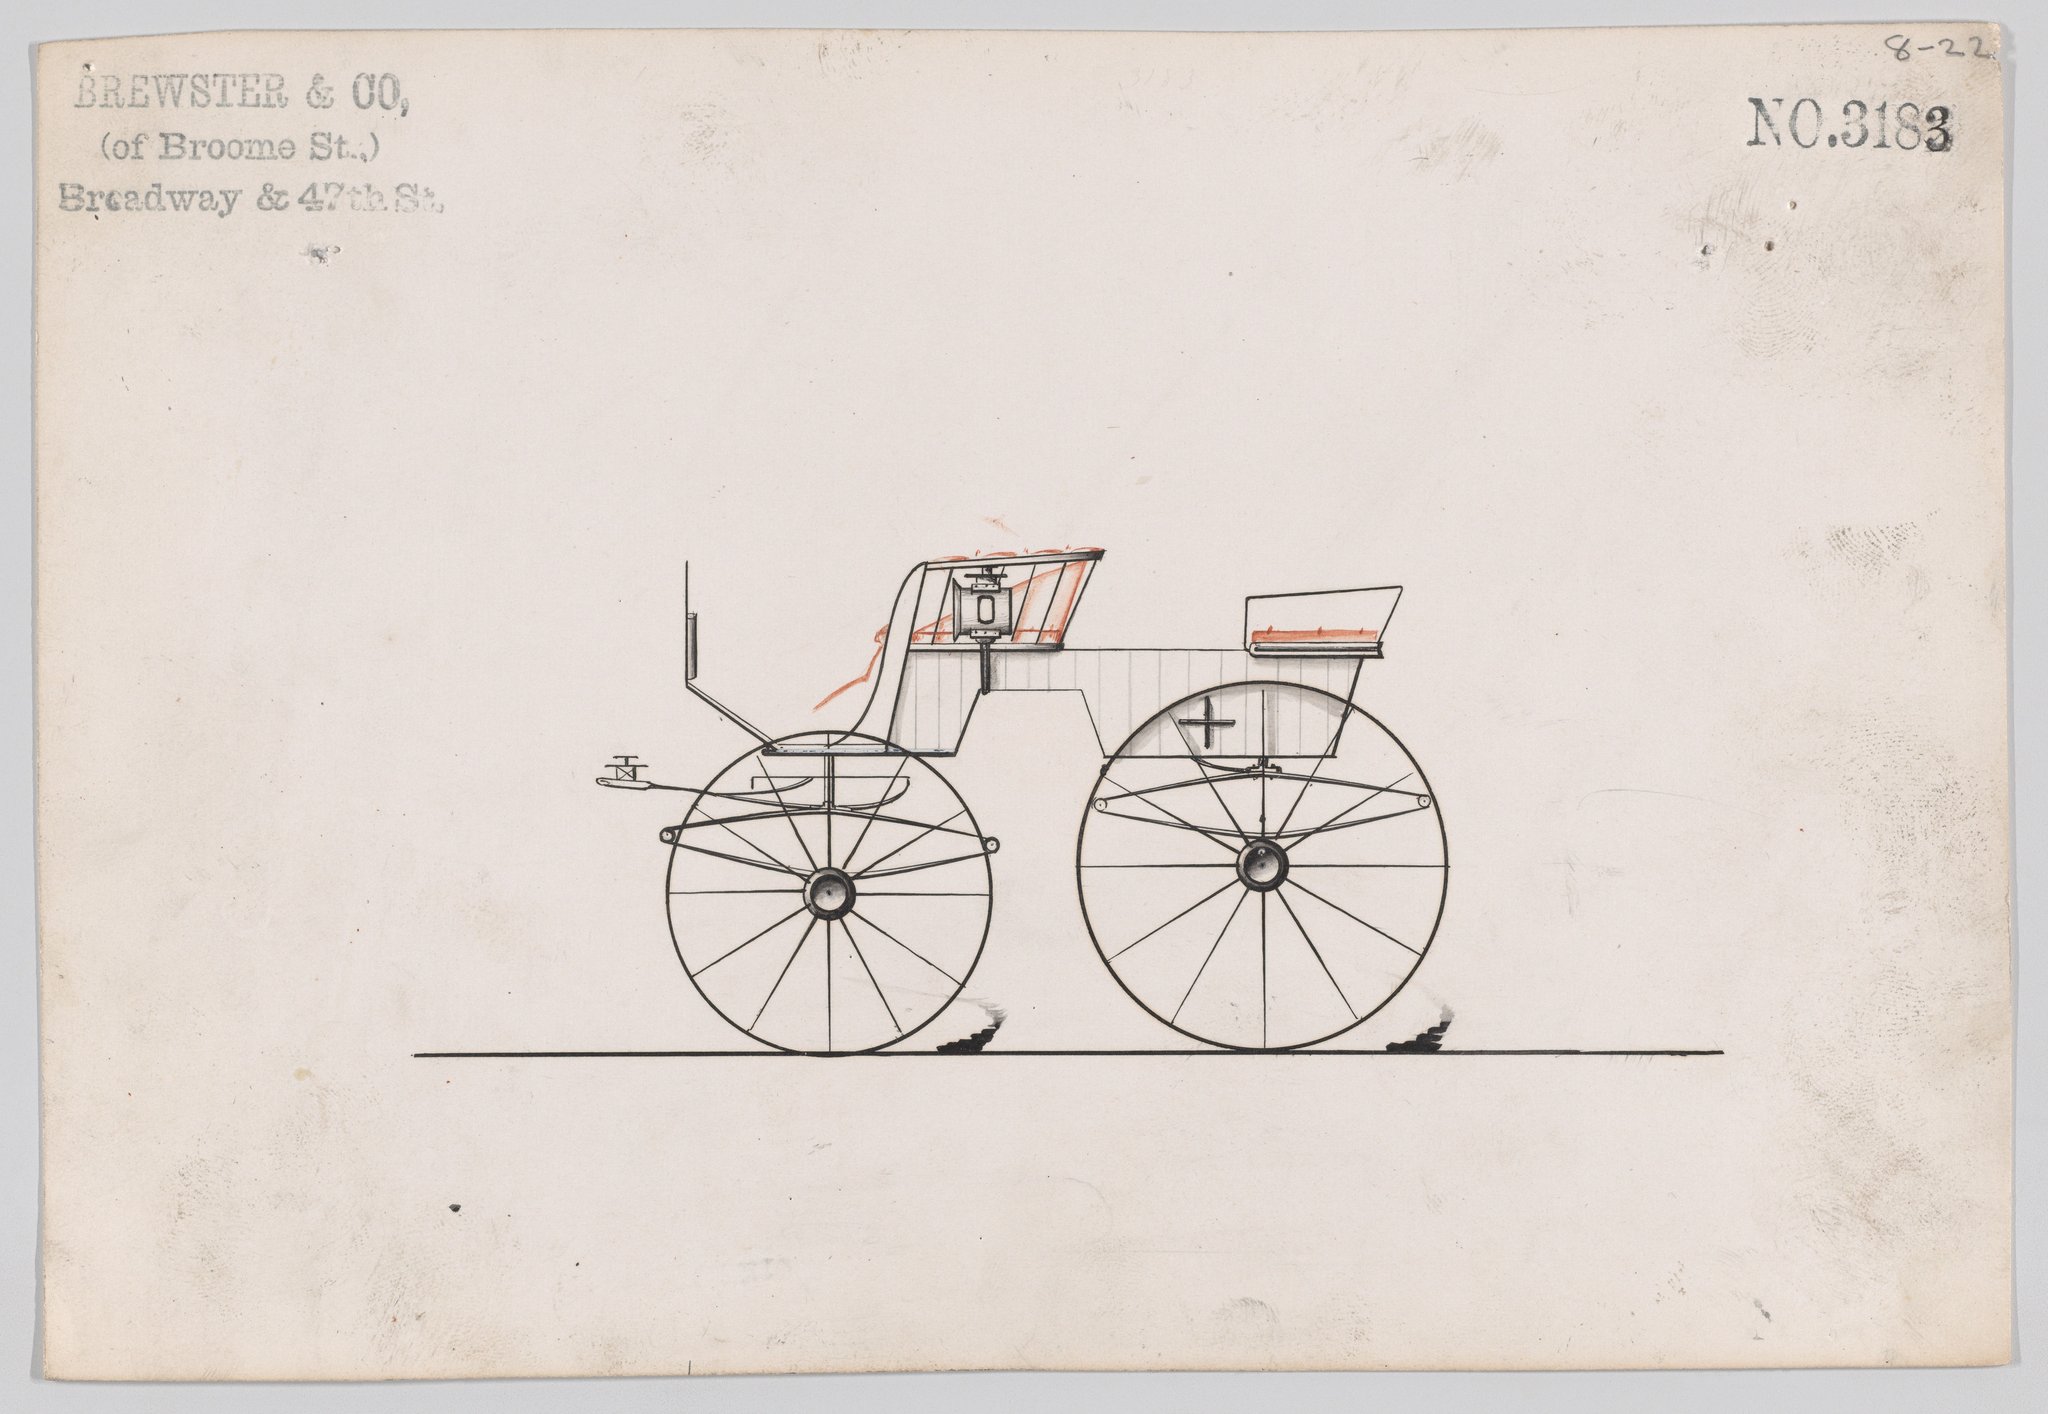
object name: drawing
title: Design for 4 seat Phaeton, no top, no. 3183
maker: brewster & co.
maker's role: manufacturer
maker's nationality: american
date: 1876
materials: ink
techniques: pen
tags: carriages